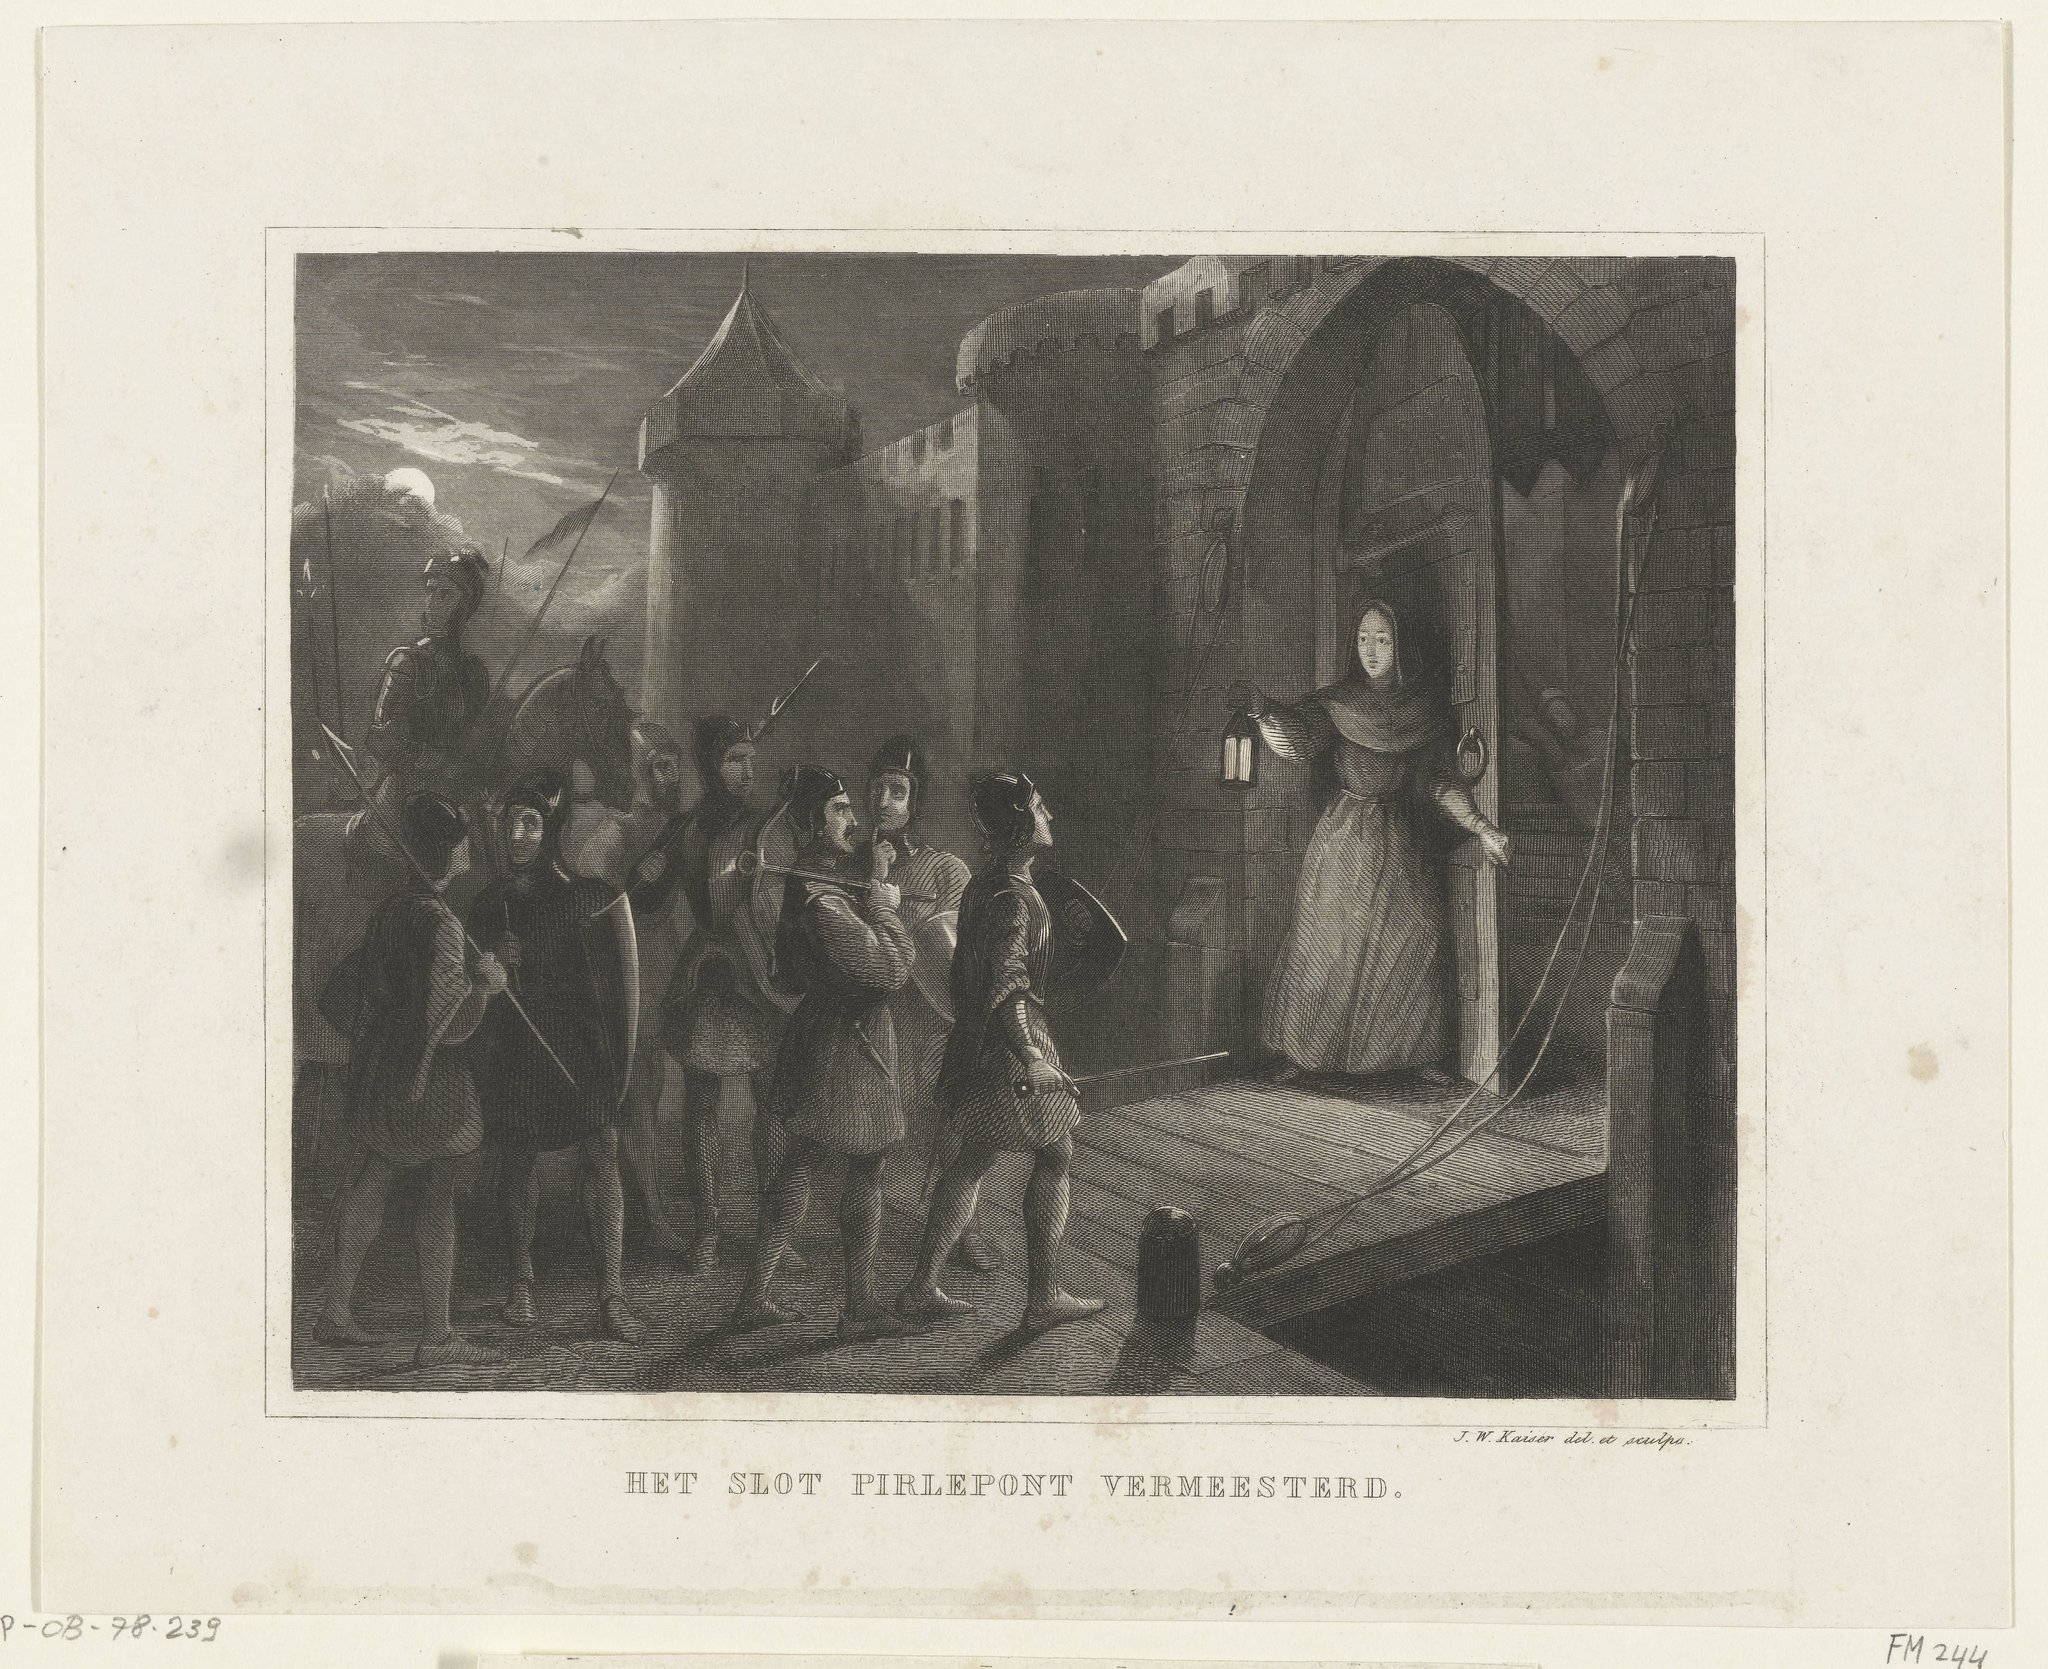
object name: print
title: Verovering van het Slot Pirlepont, 1401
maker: johann wilhelm kaiser (i)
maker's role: draughtsman, print maker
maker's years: 1813-1900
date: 1842-1844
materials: paper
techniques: engraving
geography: netherlands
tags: netherlands, burgundian netherlands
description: De moeder van Jan van Arkel verovert vermomd als een melaatse, het slot Pirlepont, 1401. De vrouw opent in de nacht de poort van het slot zodat de soldaten over de ophaalbrug binnen kunnen komen.